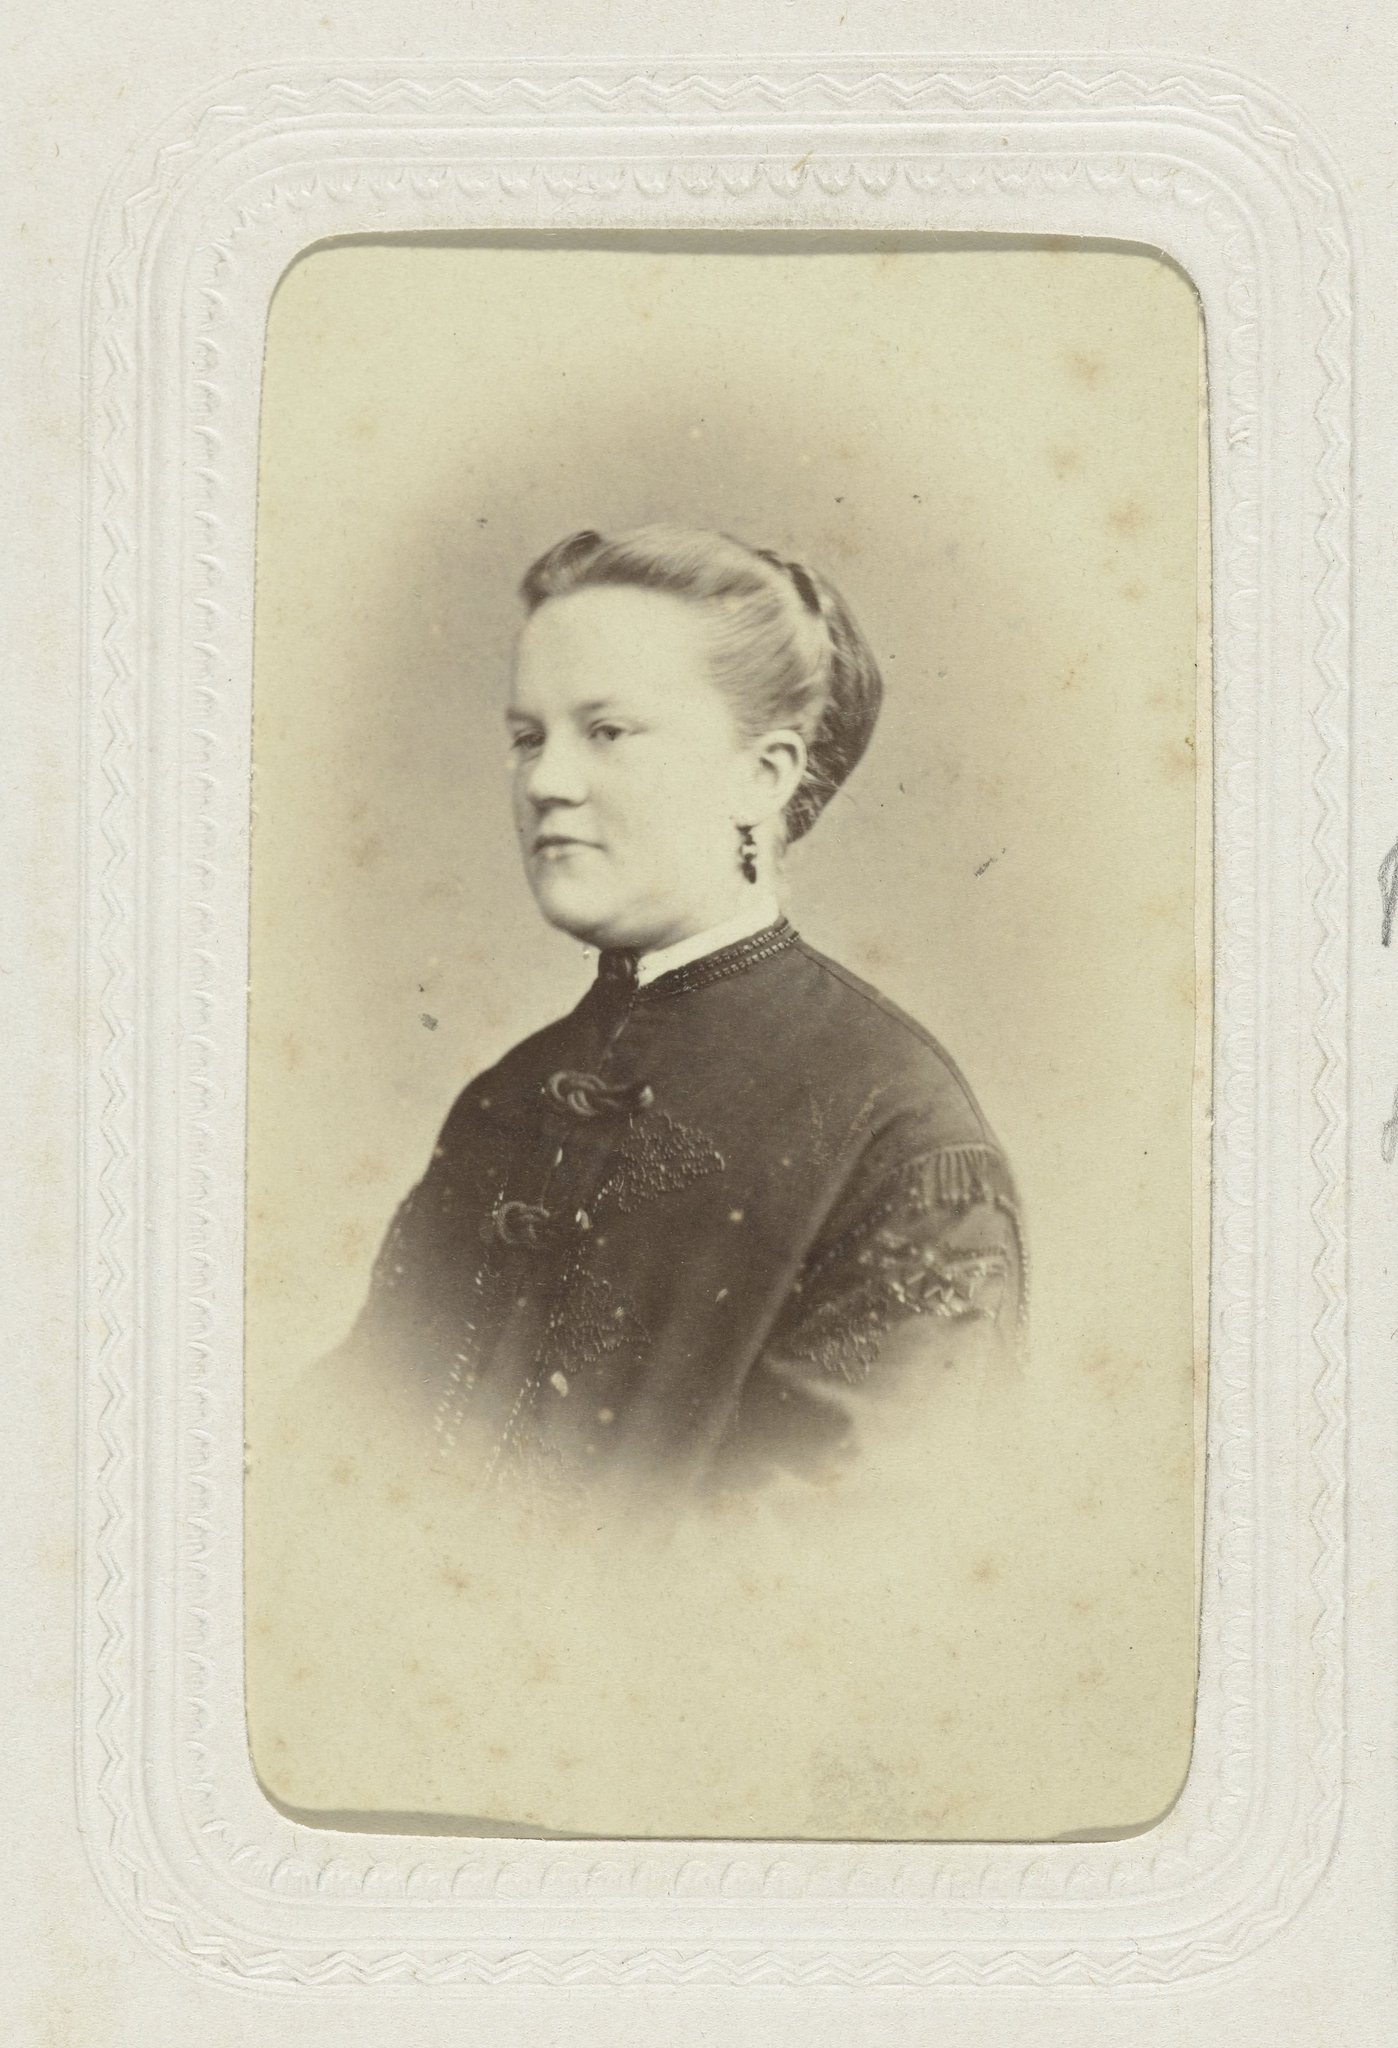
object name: carte de visite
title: Studioportret van een vrouw in klederdracht met een zwart kapje op het hoofd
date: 1863-1866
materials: cardboard, paper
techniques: albumen print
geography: haarlem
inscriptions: name: ‘Albert Greiner, Amsterdam’